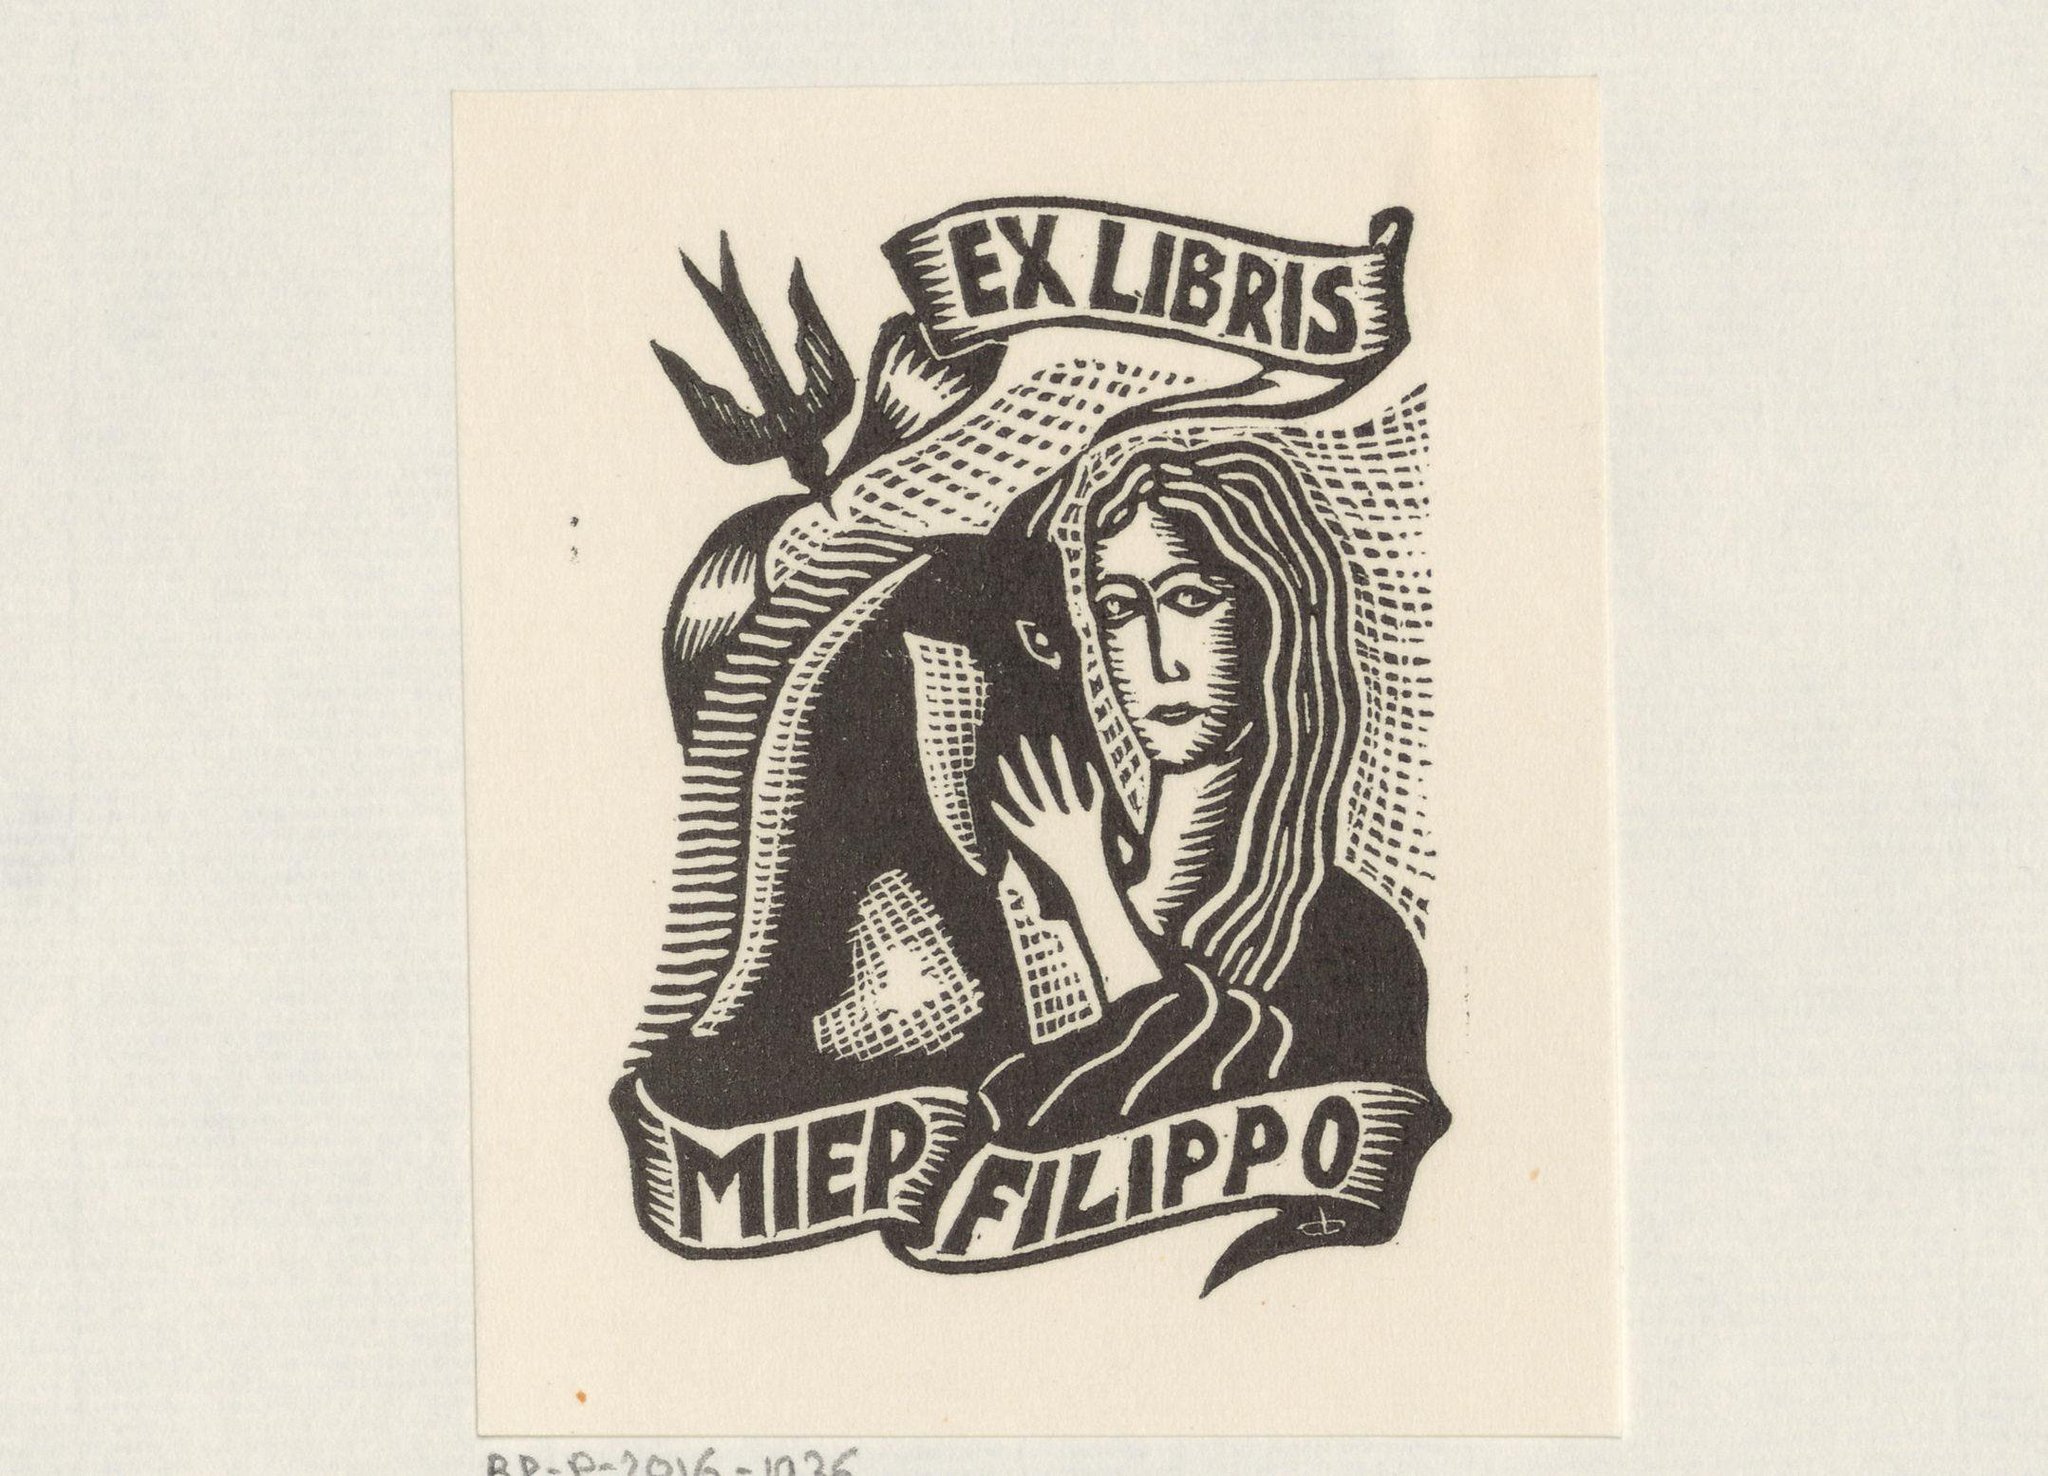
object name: bookplate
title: Ex libris van Miep Filippo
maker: dries boskamp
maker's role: print maker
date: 1937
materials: paper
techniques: woodcut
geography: netherlands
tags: artist, miep filippo, adult woman, song-birds: swallow, horse